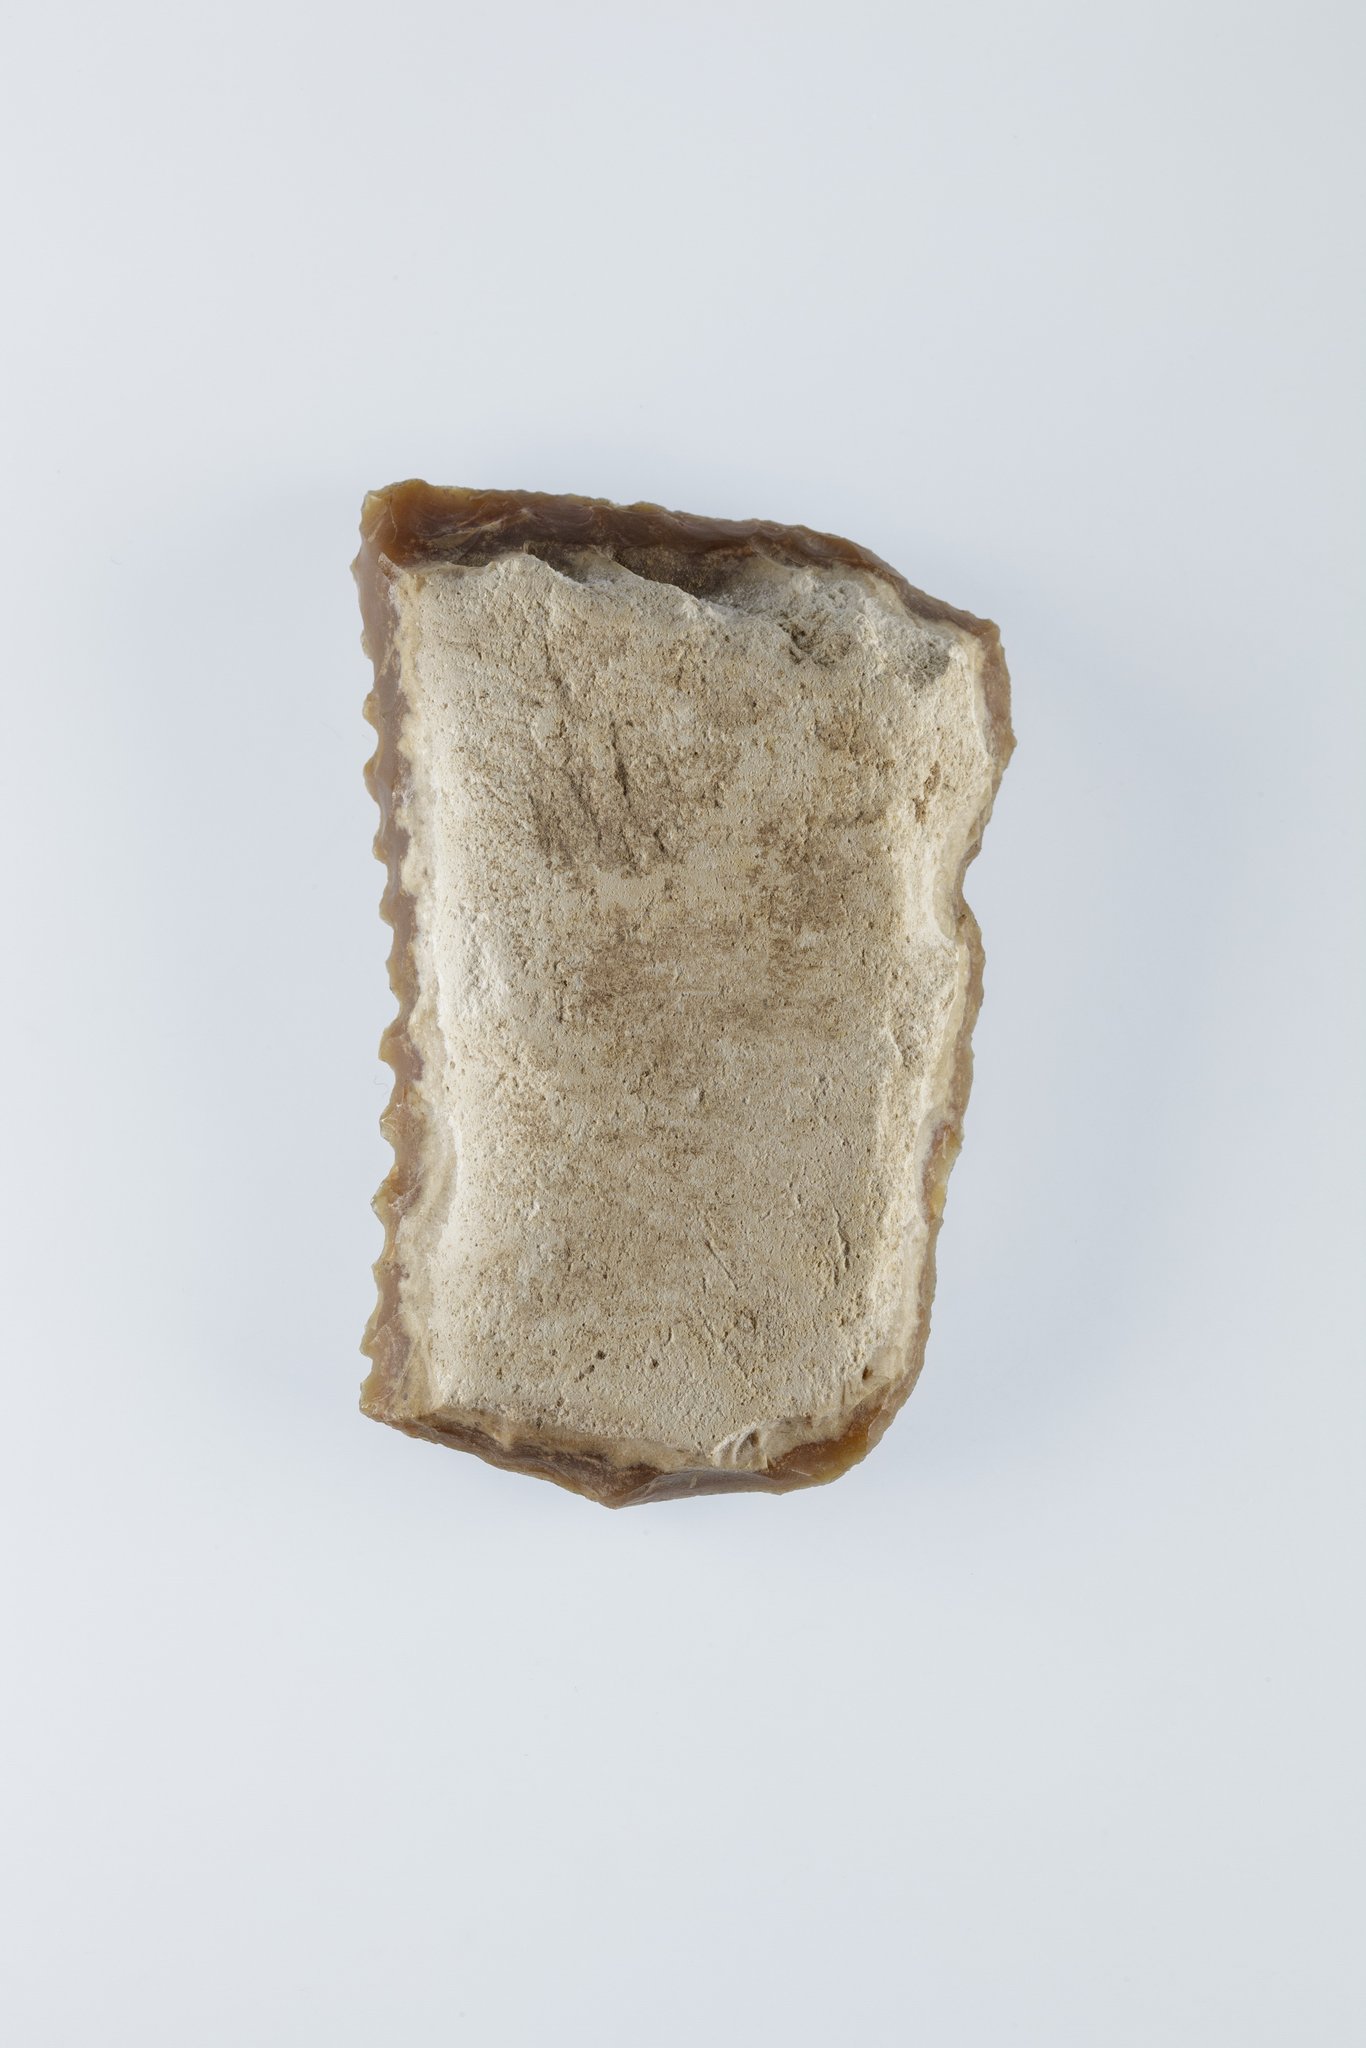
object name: sickle, insert, denticulate, backed, bi truncated, blade, tool, element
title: Sickle Insert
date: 1186-1070 BCE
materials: stone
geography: egypt